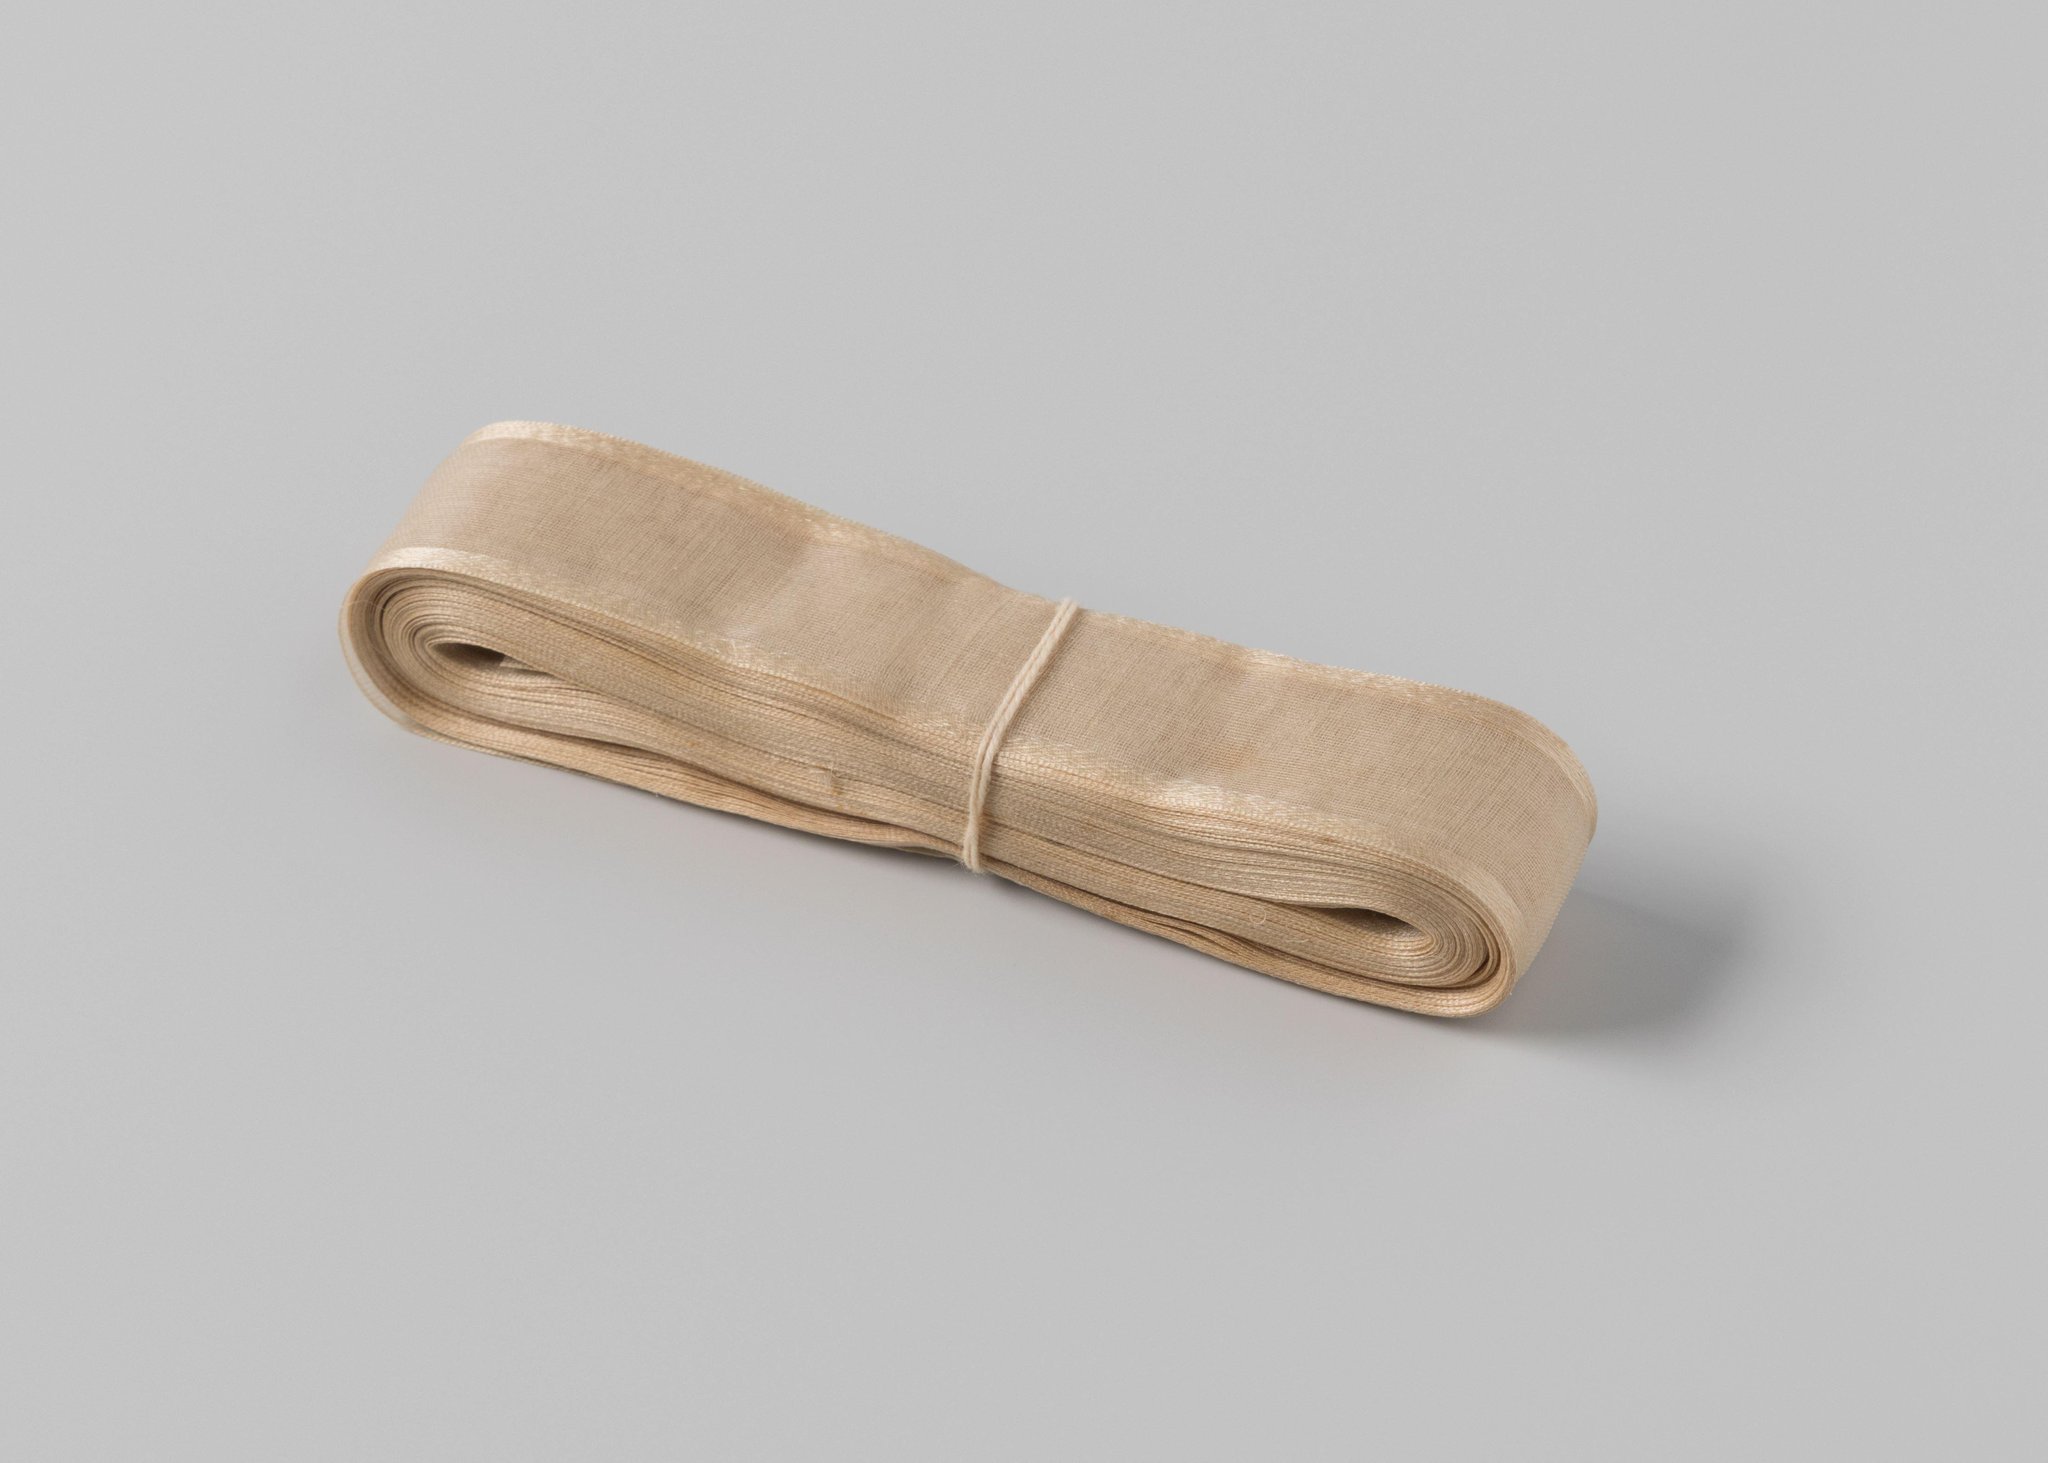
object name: ribbon material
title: Lint van crèmekleurig gaas van 15 meter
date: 1900-1915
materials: textile, silk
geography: nijmegen